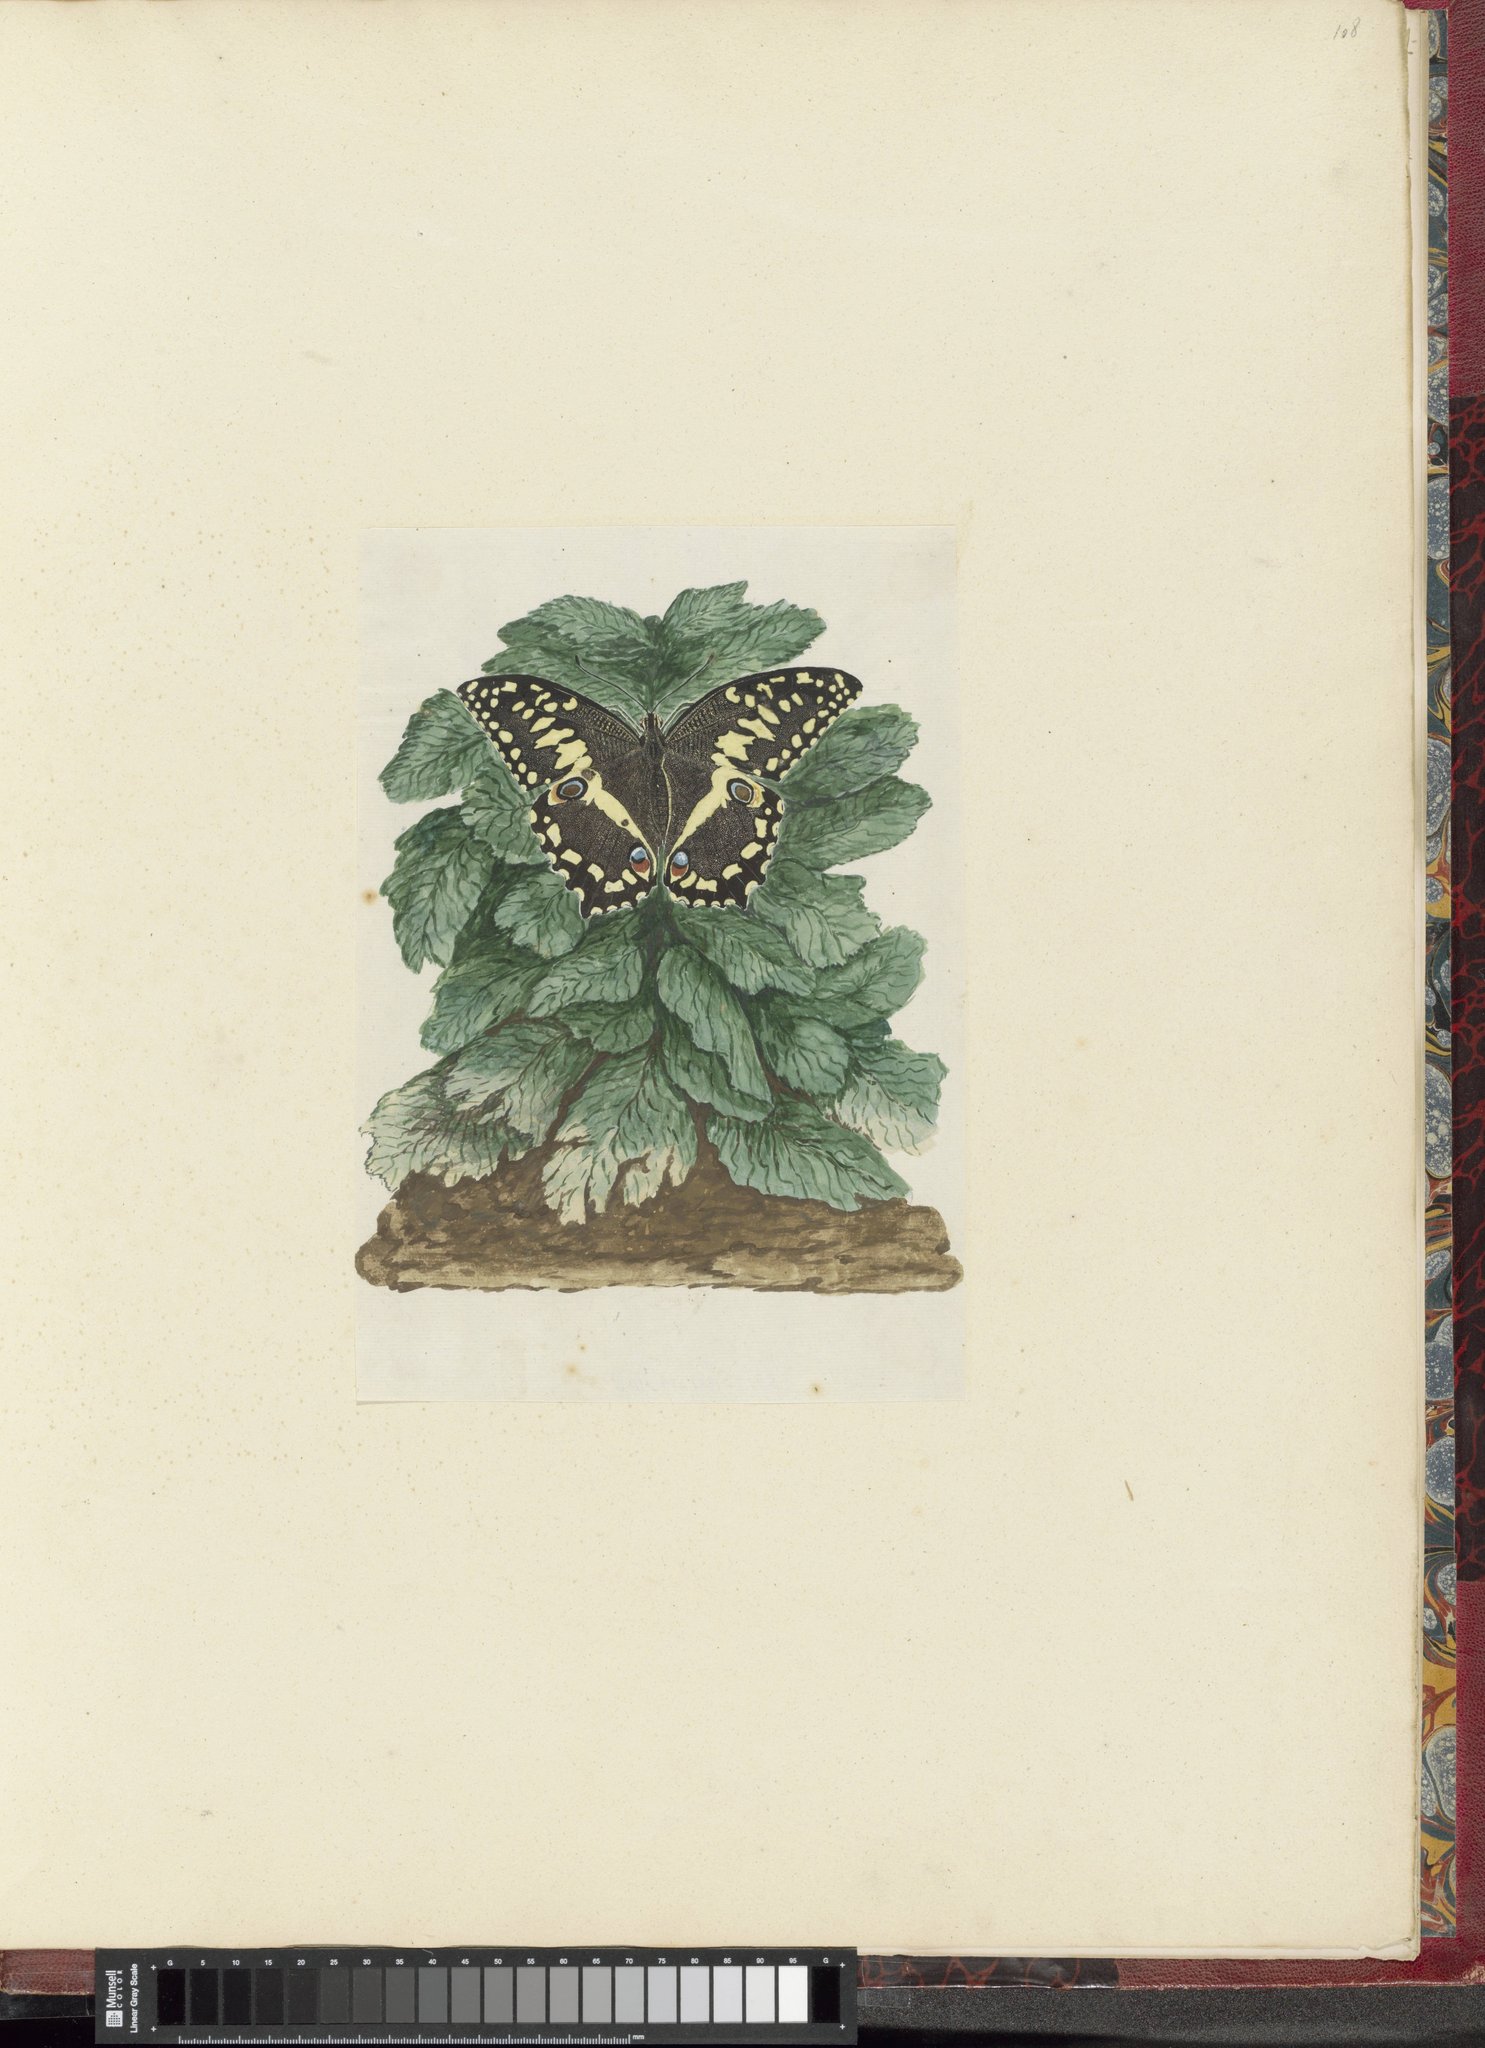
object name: album leaf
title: Papilio demodocus (Citrus or Christmas butterfly) on an unidentified plant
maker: robert jacob gordon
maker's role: draughtsman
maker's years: 1743-1795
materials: chalk, paint, ink, paper, pencil, watercolor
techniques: brush, pen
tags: plants; vegetation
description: De tekening is gemaakt voor of tijdens een van Gordon's vier expedities door de Kaapprovincie, van oktober 1777 tot maart 1786. Sommige (soort)namen kunnen zijn gewijzigd, gezien reorganisatie in plantentaxonomie gedurende de afgelopen jaren.